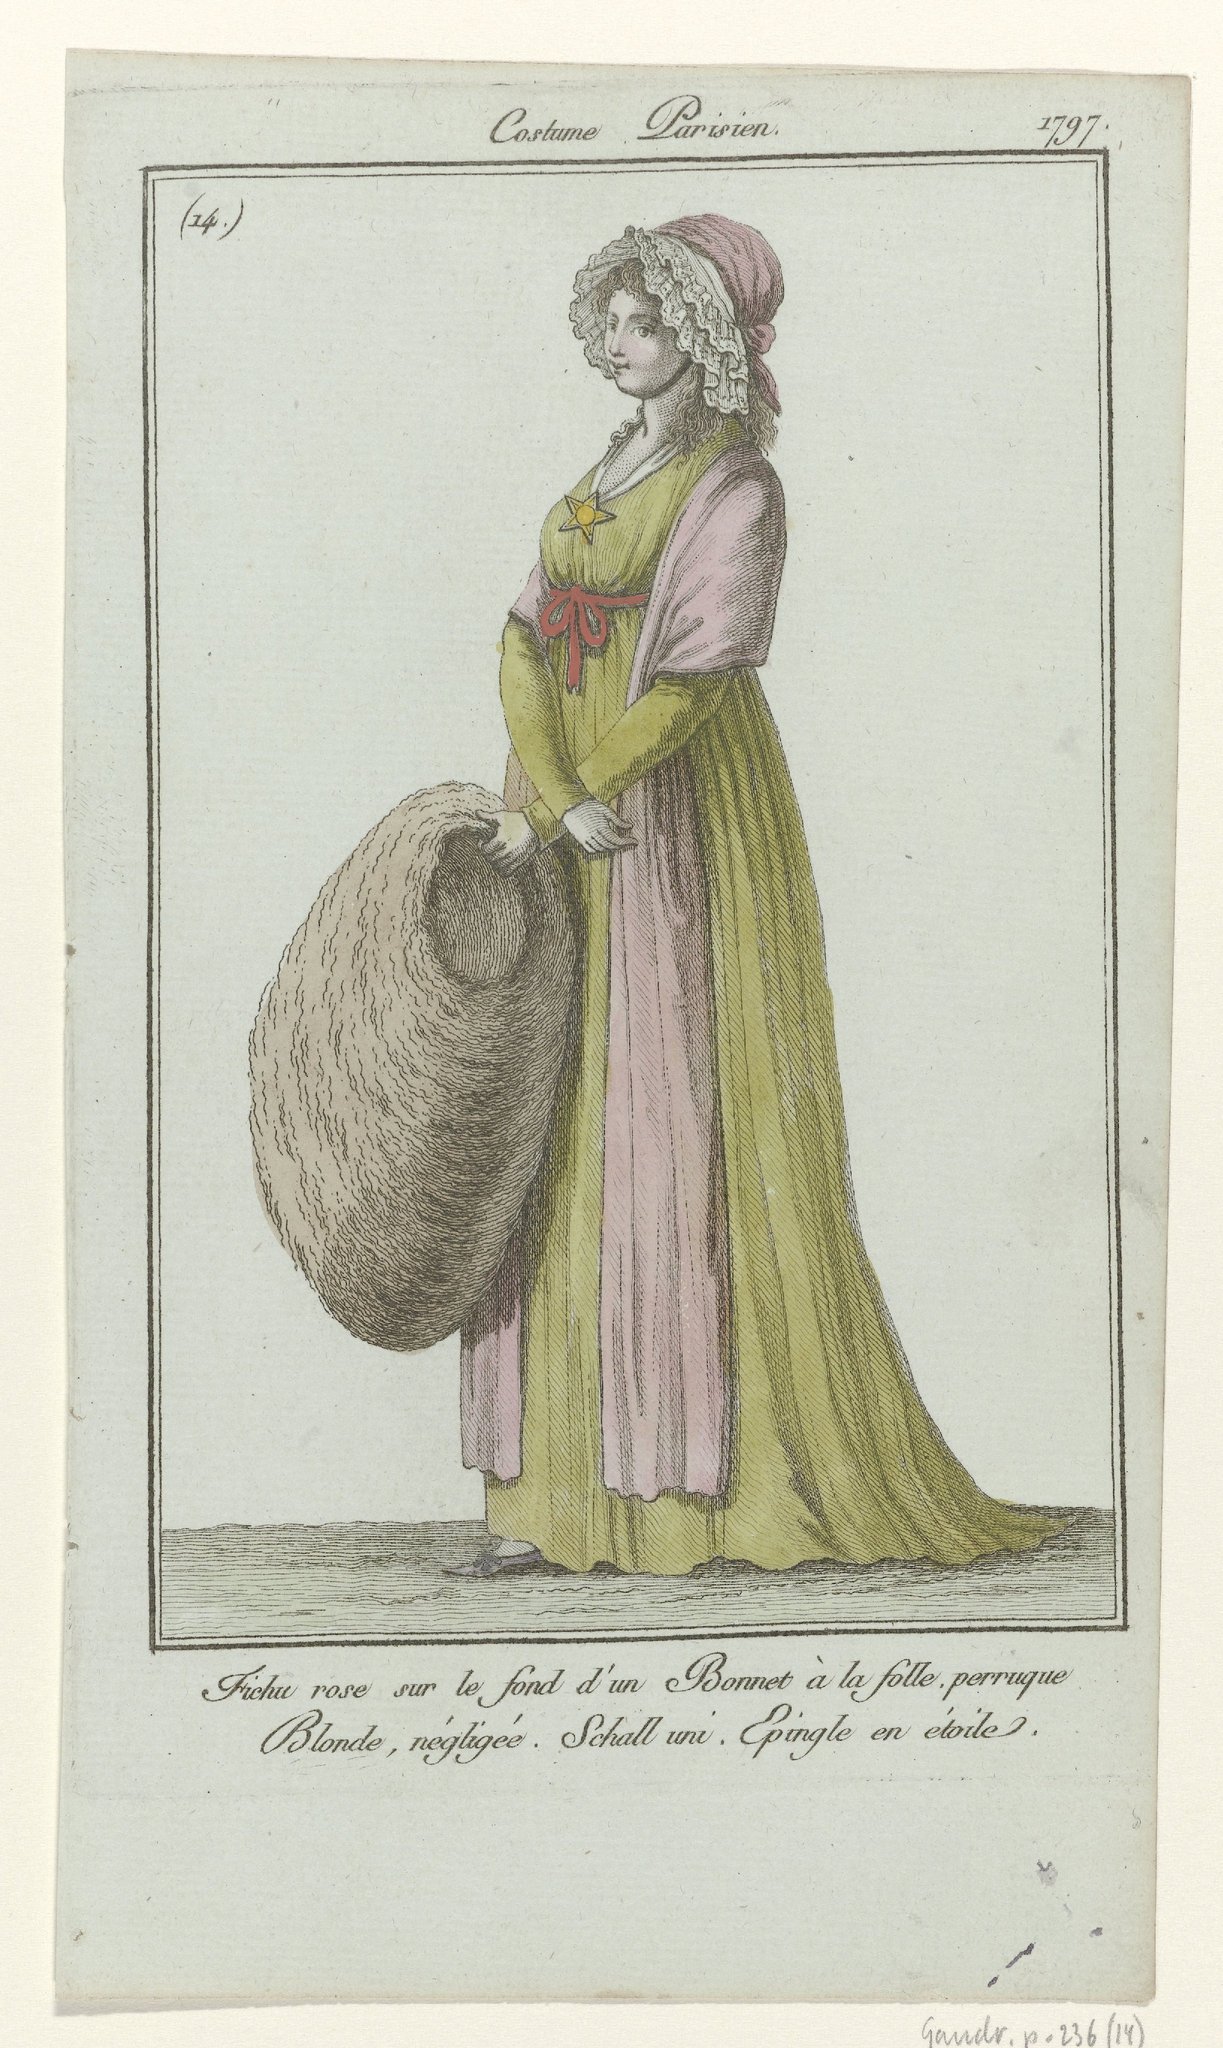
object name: fashion print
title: Journal des Dames et des Modes, Costume Parisien, 10 décembre 1797, (14) : Fichu rose sur le fond (...)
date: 1797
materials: paper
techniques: engraving, hand coloring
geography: paris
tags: brooch, agraffe, clasp (+ women's clothes), clothing for the upper part of the body (shawl) (+ women's clothes), styles of hairdress - aa - ~ women, head-gear: cap (+ women's clothes), fashion plates, shoes, sandals (+ women's clothes), dress, gown (+ women's clothes), muff (+ fur used for clothes), piece of clothing covering the breast or décolleté (fichu) (+ women's clothes)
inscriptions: caption: ‘Fichu rose sur le fond d'un Bonnet à la folle. perruque Blonde, négligée. Schall uni. Epingle en étoile.’, title: ‘Costume Parisien.’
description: 'Bonnet à la folle' : roze fichu om de bol van een muts op een blonde pruik. Japon met sleep of 'negligée'(?) en een effen lange sjaal. Stervormige speld (broche) bij het decolleté. Verdere accessoires: grote mof van bont, schoen met puntige neus en strik. De prent maakt deel uit van het modetijdschrift Journal des Dames et des Modes, uitgegeven door Sellèque, Parijs, 1797-1839.